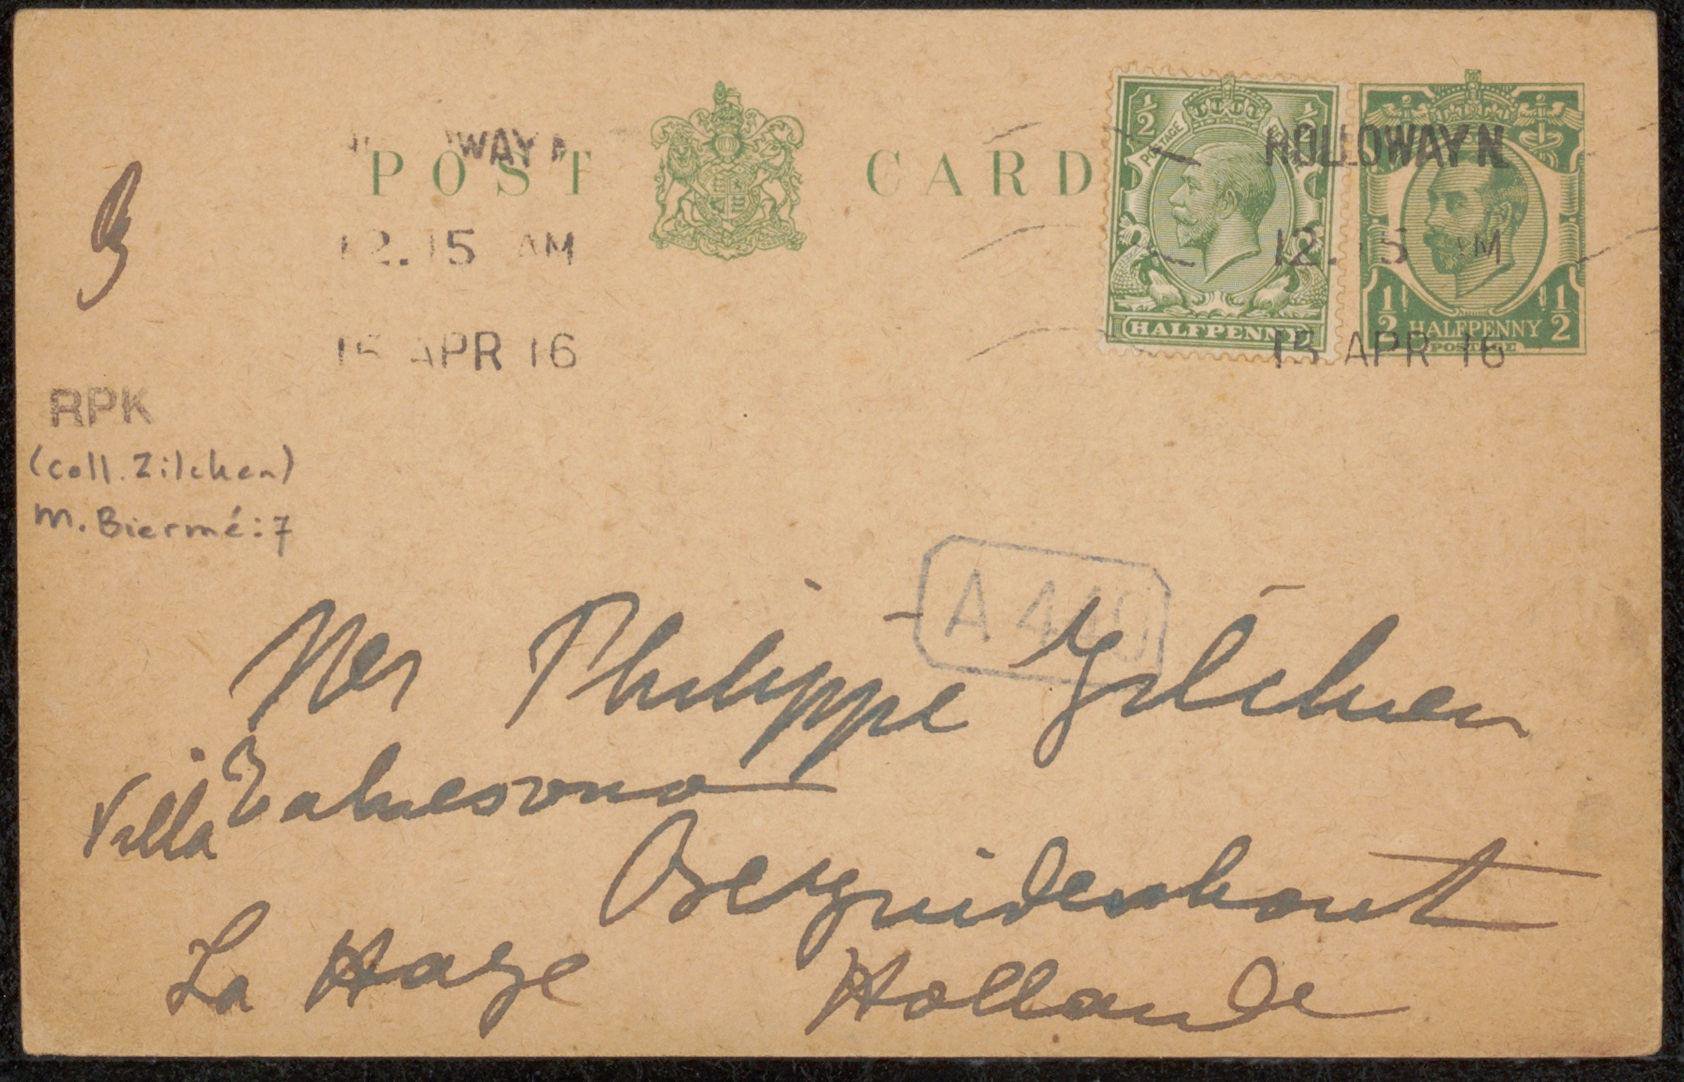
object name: postcard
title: Briefkaart aan Philip Zilcken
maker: maria biermé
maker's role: dichter, schrijver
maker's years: 1863-1932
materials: cardboard, ink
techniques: pen, writing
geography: london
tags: mechelen, amsterdam, print maker, draughtsman, rik wouters, delft, willem paerels, the hague, painter, philip zilcken, paris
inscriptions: collector's mark: ‘RPK’